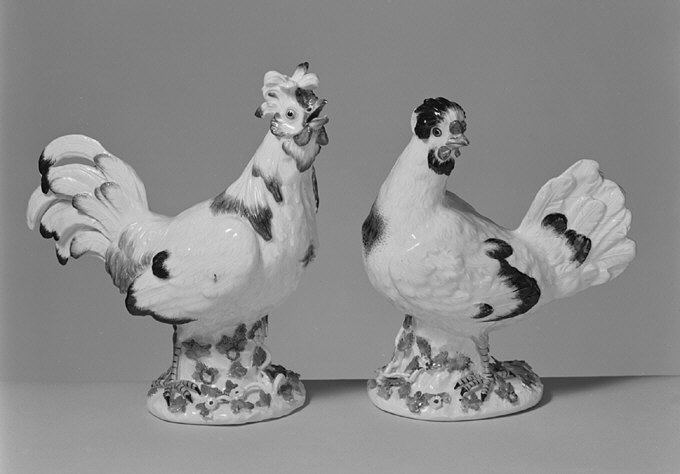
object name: figure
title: Hen (one of a pair)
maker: meissen manufactory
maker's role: manufactory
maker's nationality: german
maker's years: 1710-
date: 1742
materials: hard paste porcelain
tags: chickens